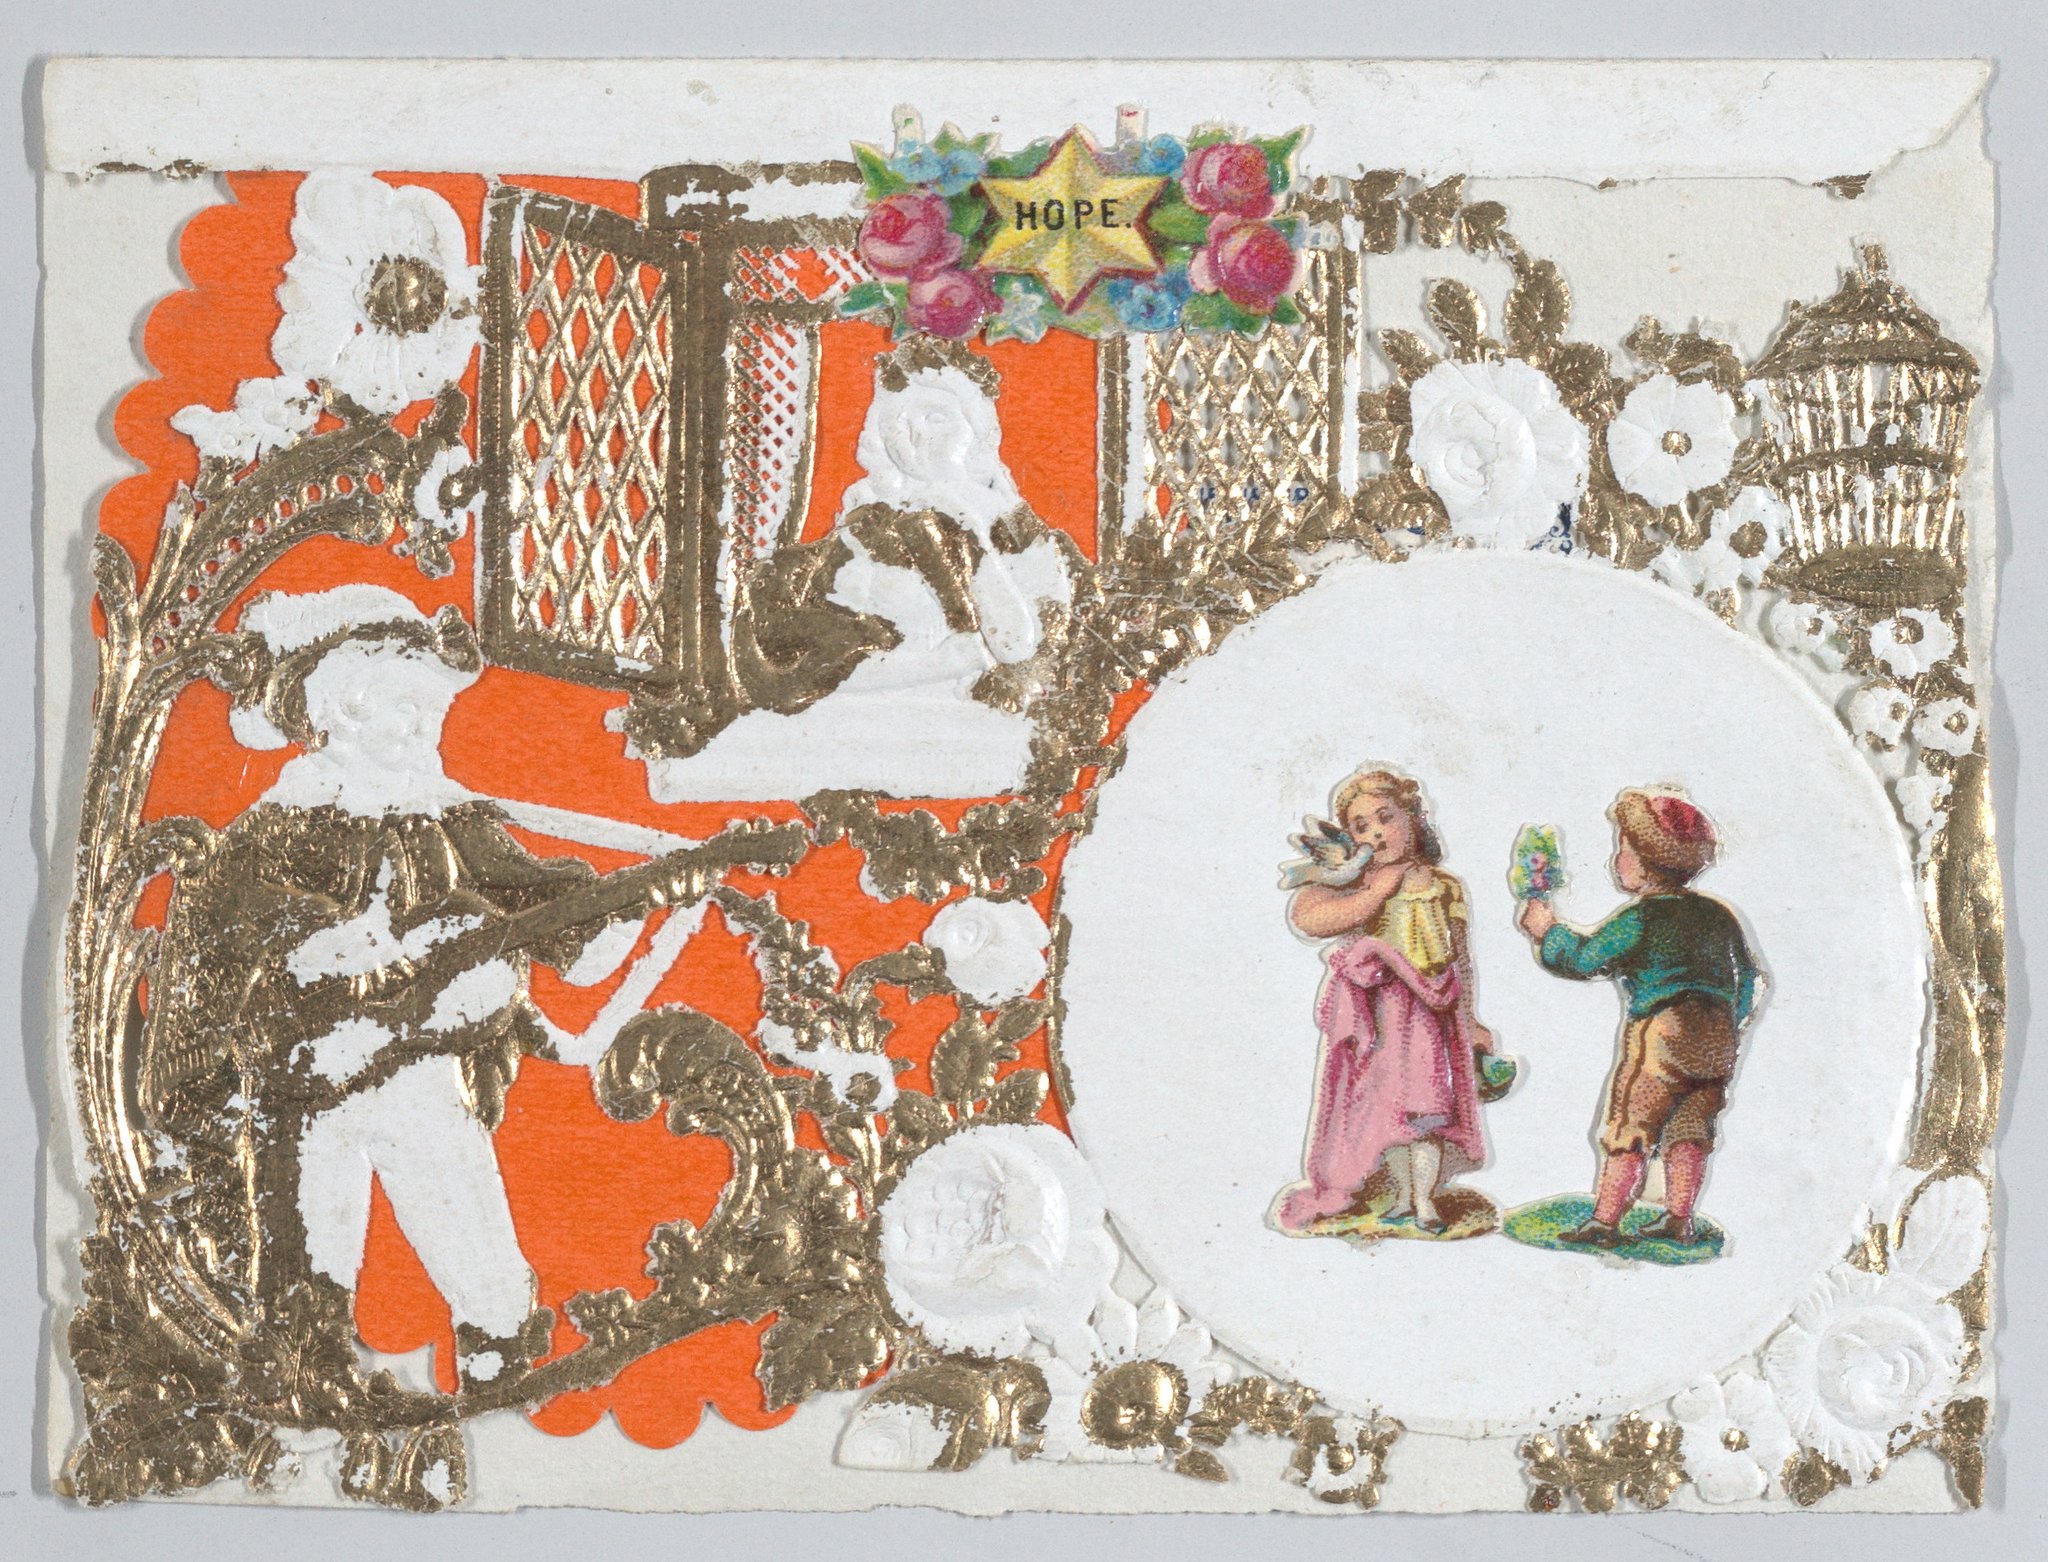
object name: valentine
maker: esther howland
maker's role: artist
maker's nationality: american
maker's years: 1828-1904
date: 1850-1870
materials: paper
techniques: chromolithography, embossing, gilding, open work